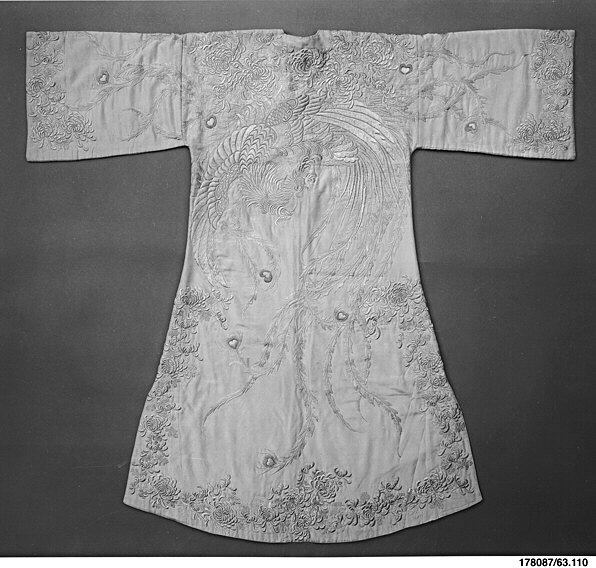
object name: woman's overcoat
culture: japanese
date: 1867-1900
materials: metal thread, silk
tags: birds